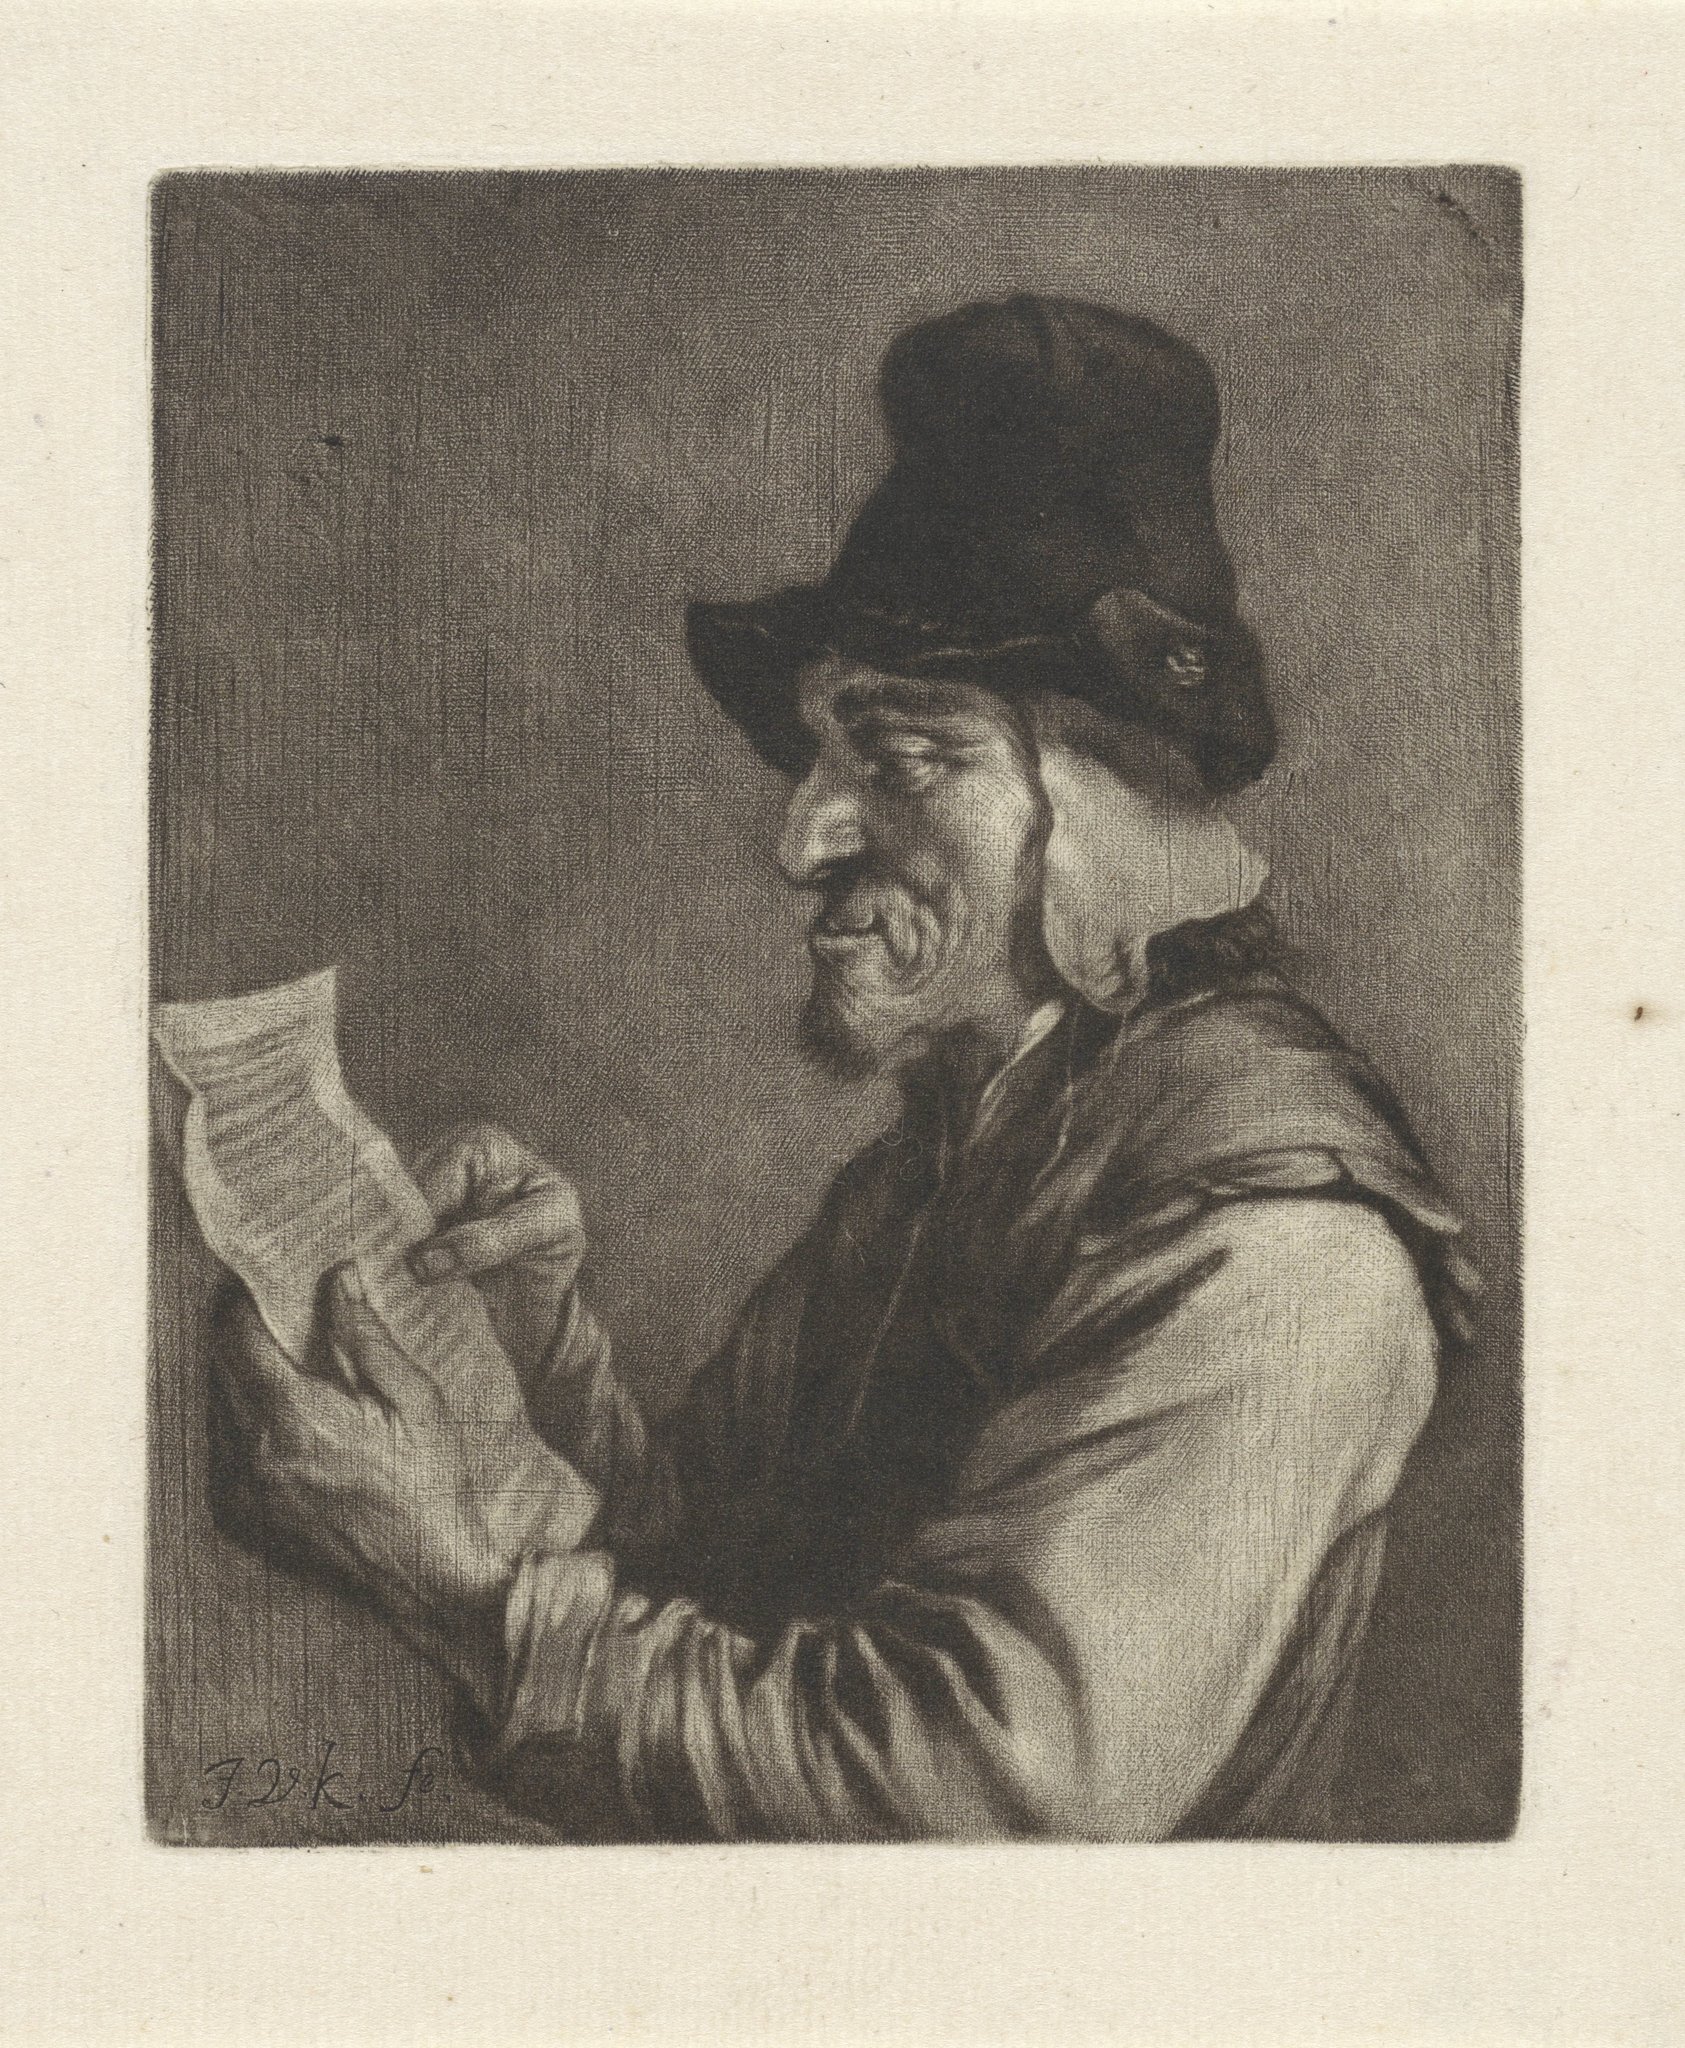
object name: print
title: Brieflezende man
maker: jan verkolje (i)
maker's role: draughtsman, painter, print maker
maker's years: 1650-1693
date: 1660-1693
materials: paper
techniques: mezzotint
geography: delft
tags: reading, letter, envelope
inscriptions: collector's mark: Lugt 240